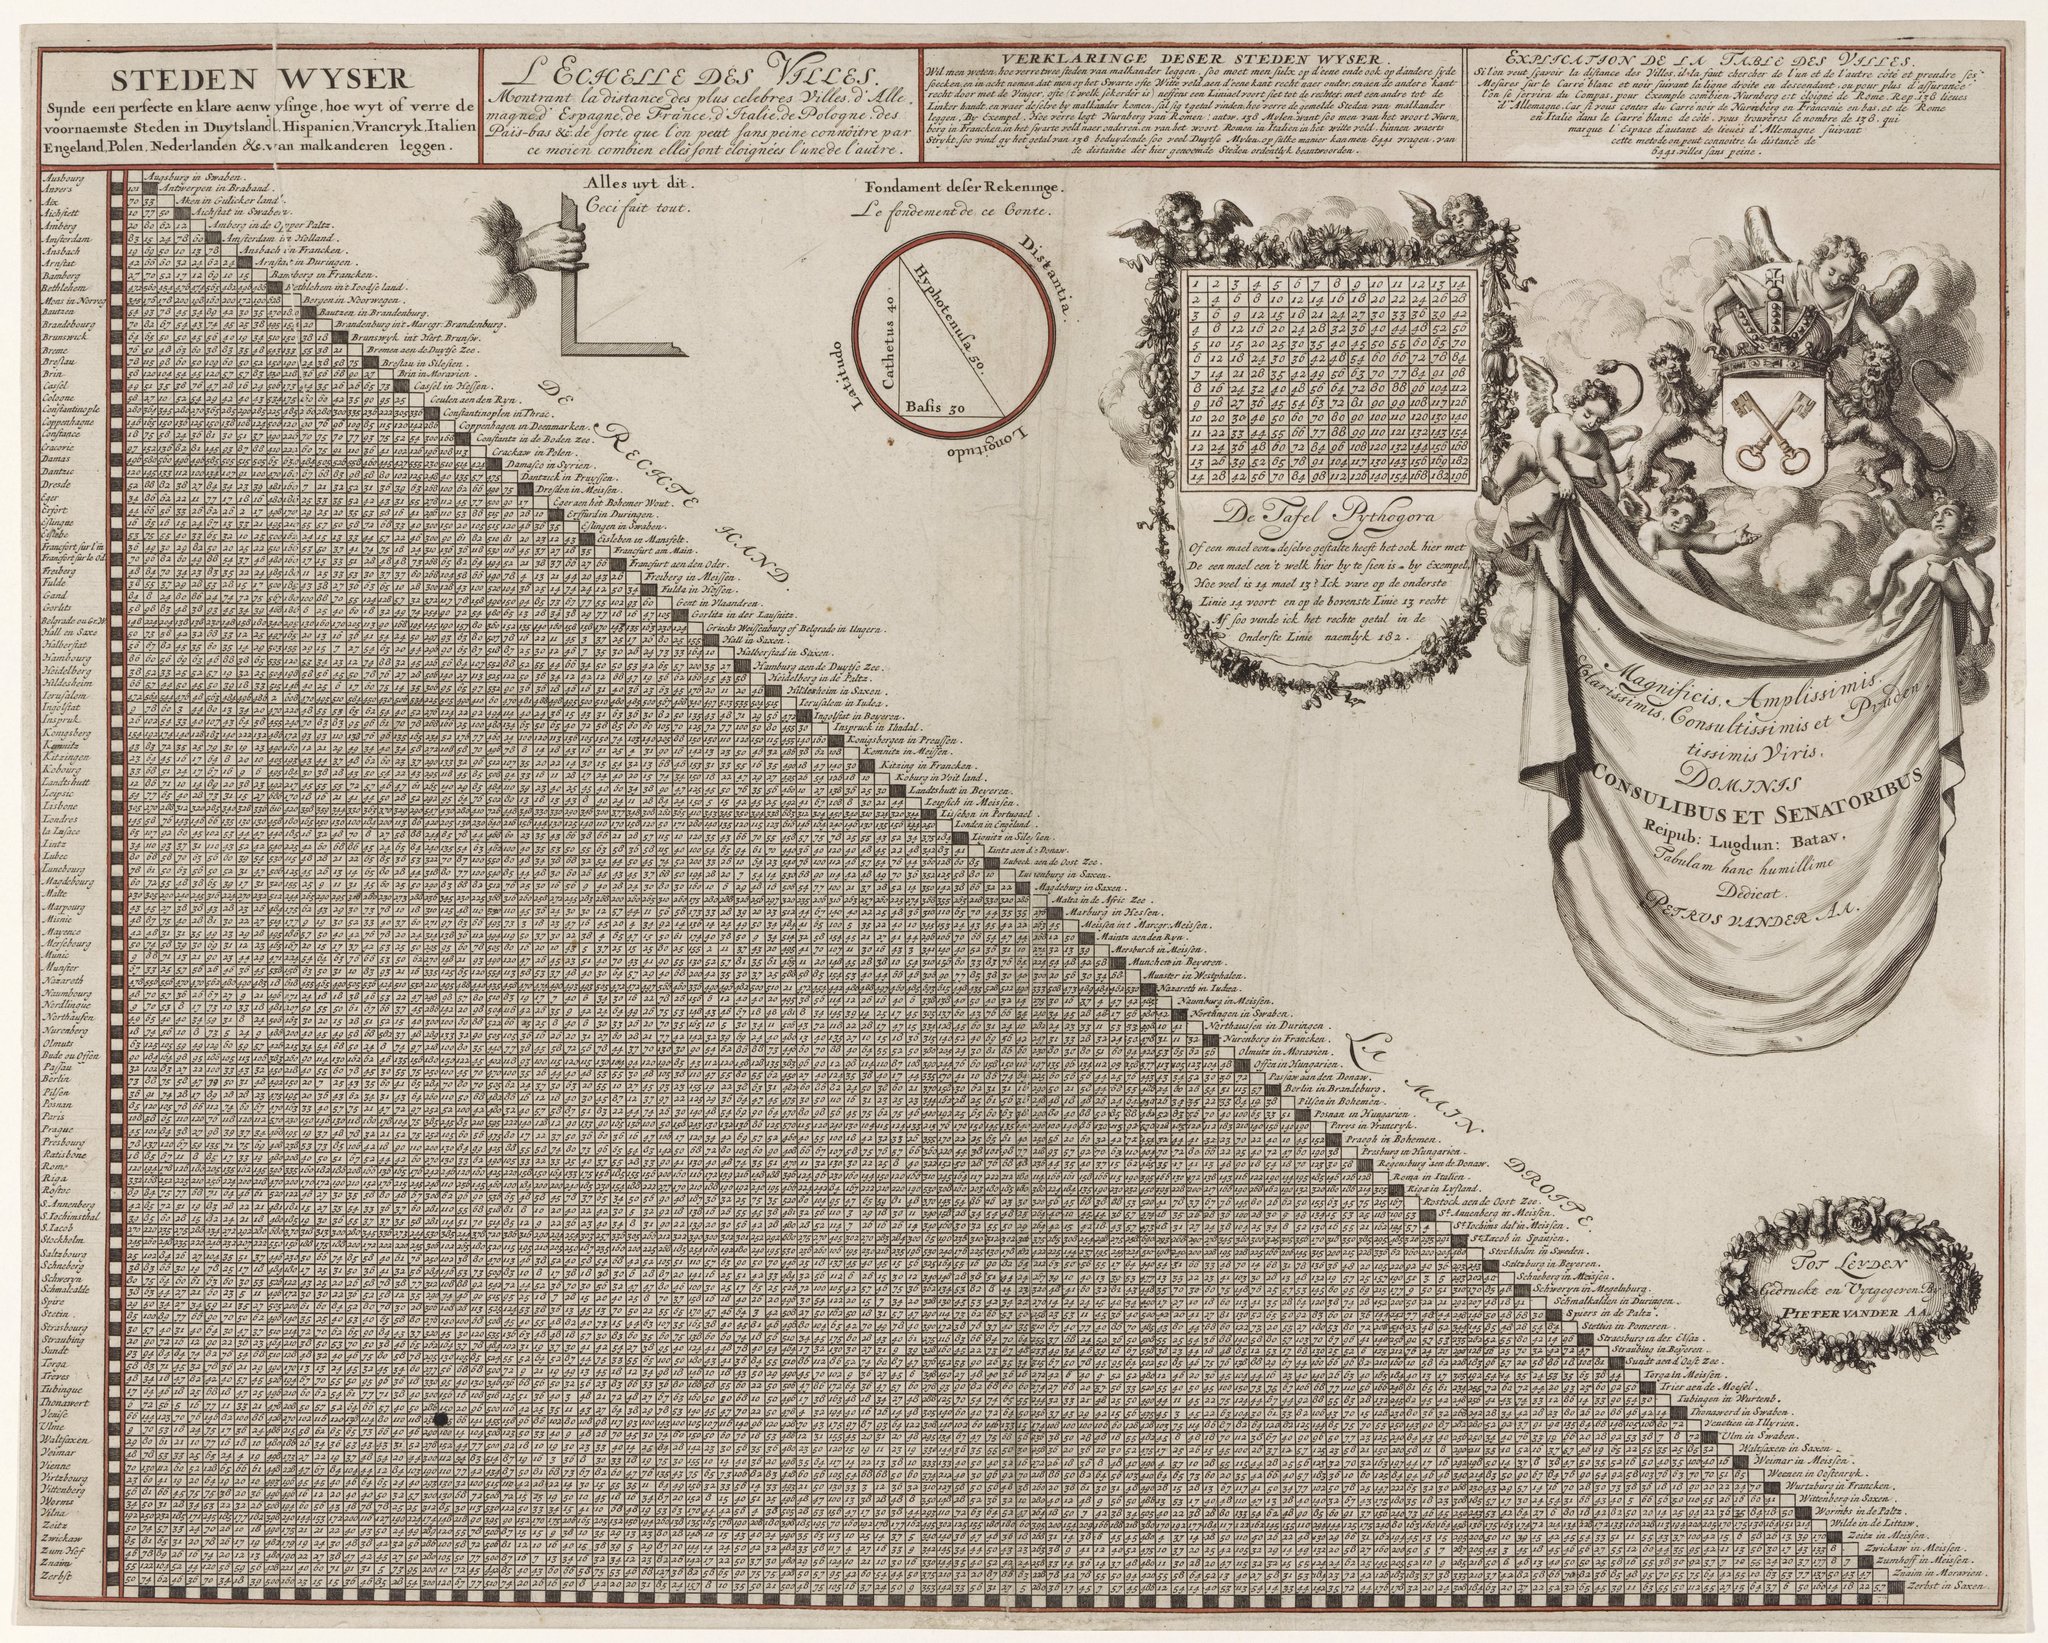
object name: print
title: Afstandstabel voor enkele plaatsen in Europa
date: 1682-1730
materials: paper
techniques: engraving, etching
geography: leiden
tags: compass (+ variant), cupids: 'amores', 'amoretti', 'putti'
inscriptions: collector's mark: Lugt 2228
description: Afstandstabel waarin staat wat de onderlinge afstand is van een aantal belangrijke steden in Duitsland, Spanje, Frankrijk, Italië, Engeland, Polen en Nederland. Bovenaan de gebruiksaanwijzing in het Nederlands en Frans. Rechts de 'Tafel van Pythogora' met een verklaring. Geheel rechts het wapenschild van Leiden, gekroond met de keizerskroon.